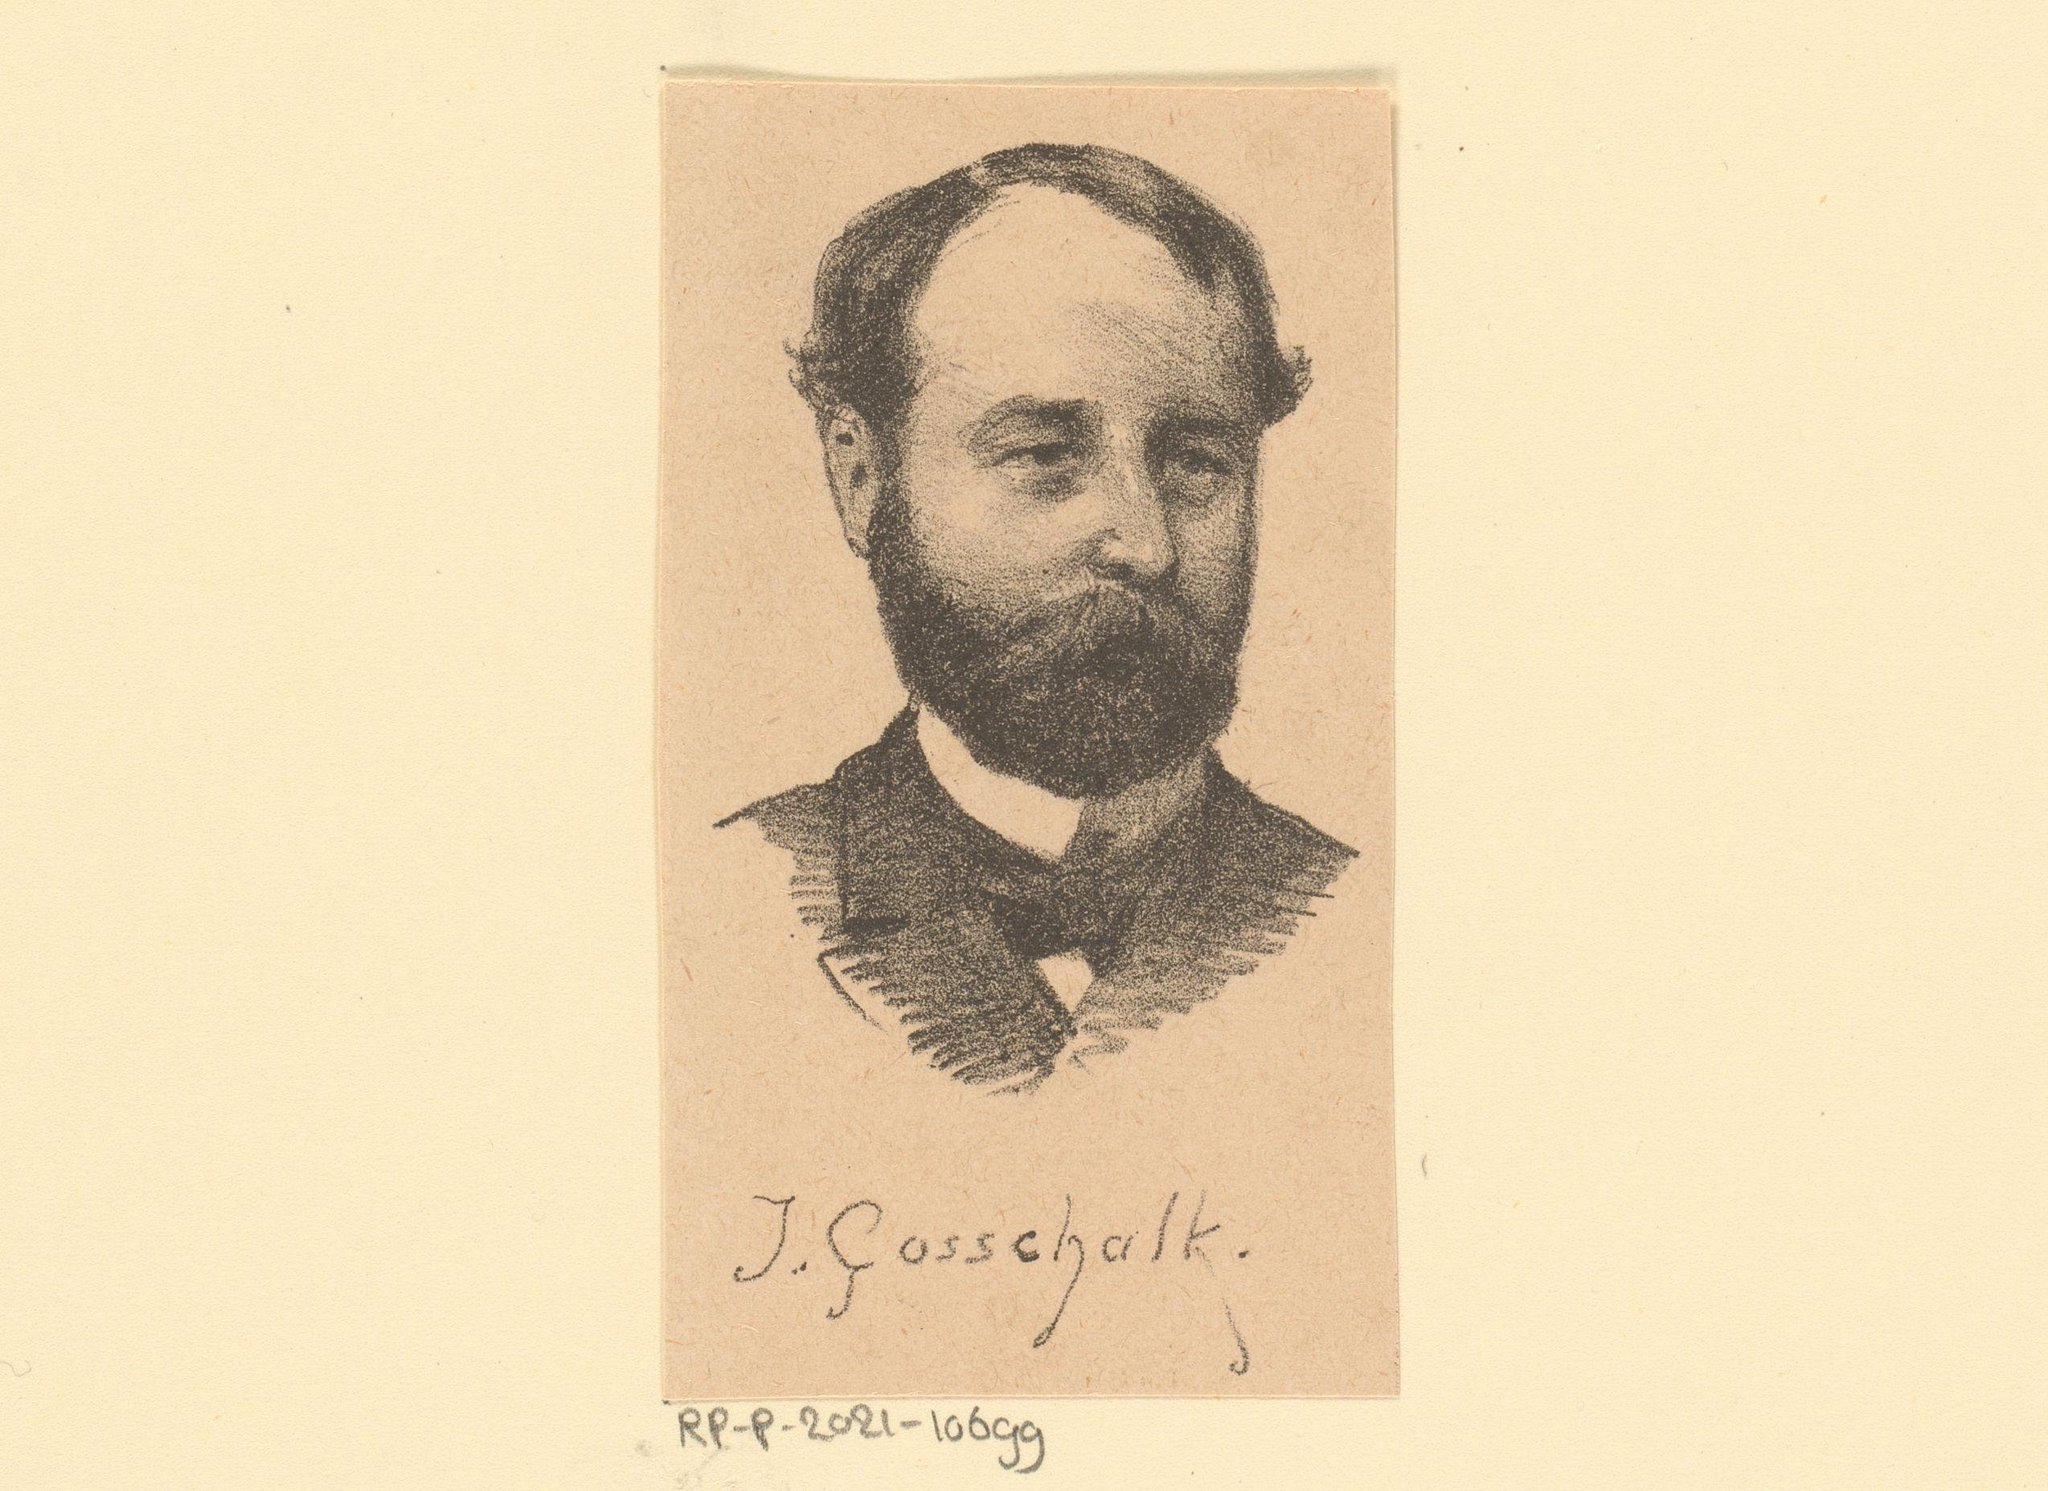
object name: print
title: Portret van Isaac Gosschalk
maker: Anonymous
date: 1838-1907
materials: paper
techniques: lithograph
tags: brussels, draughtsman, isaac gosschalk, historical persons